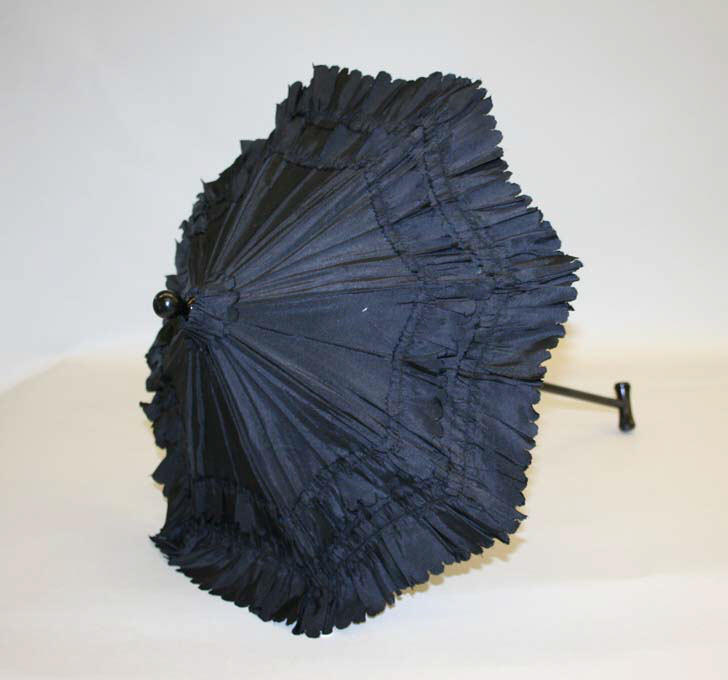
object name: parasol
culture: american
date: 1874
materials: metal, silk, wood